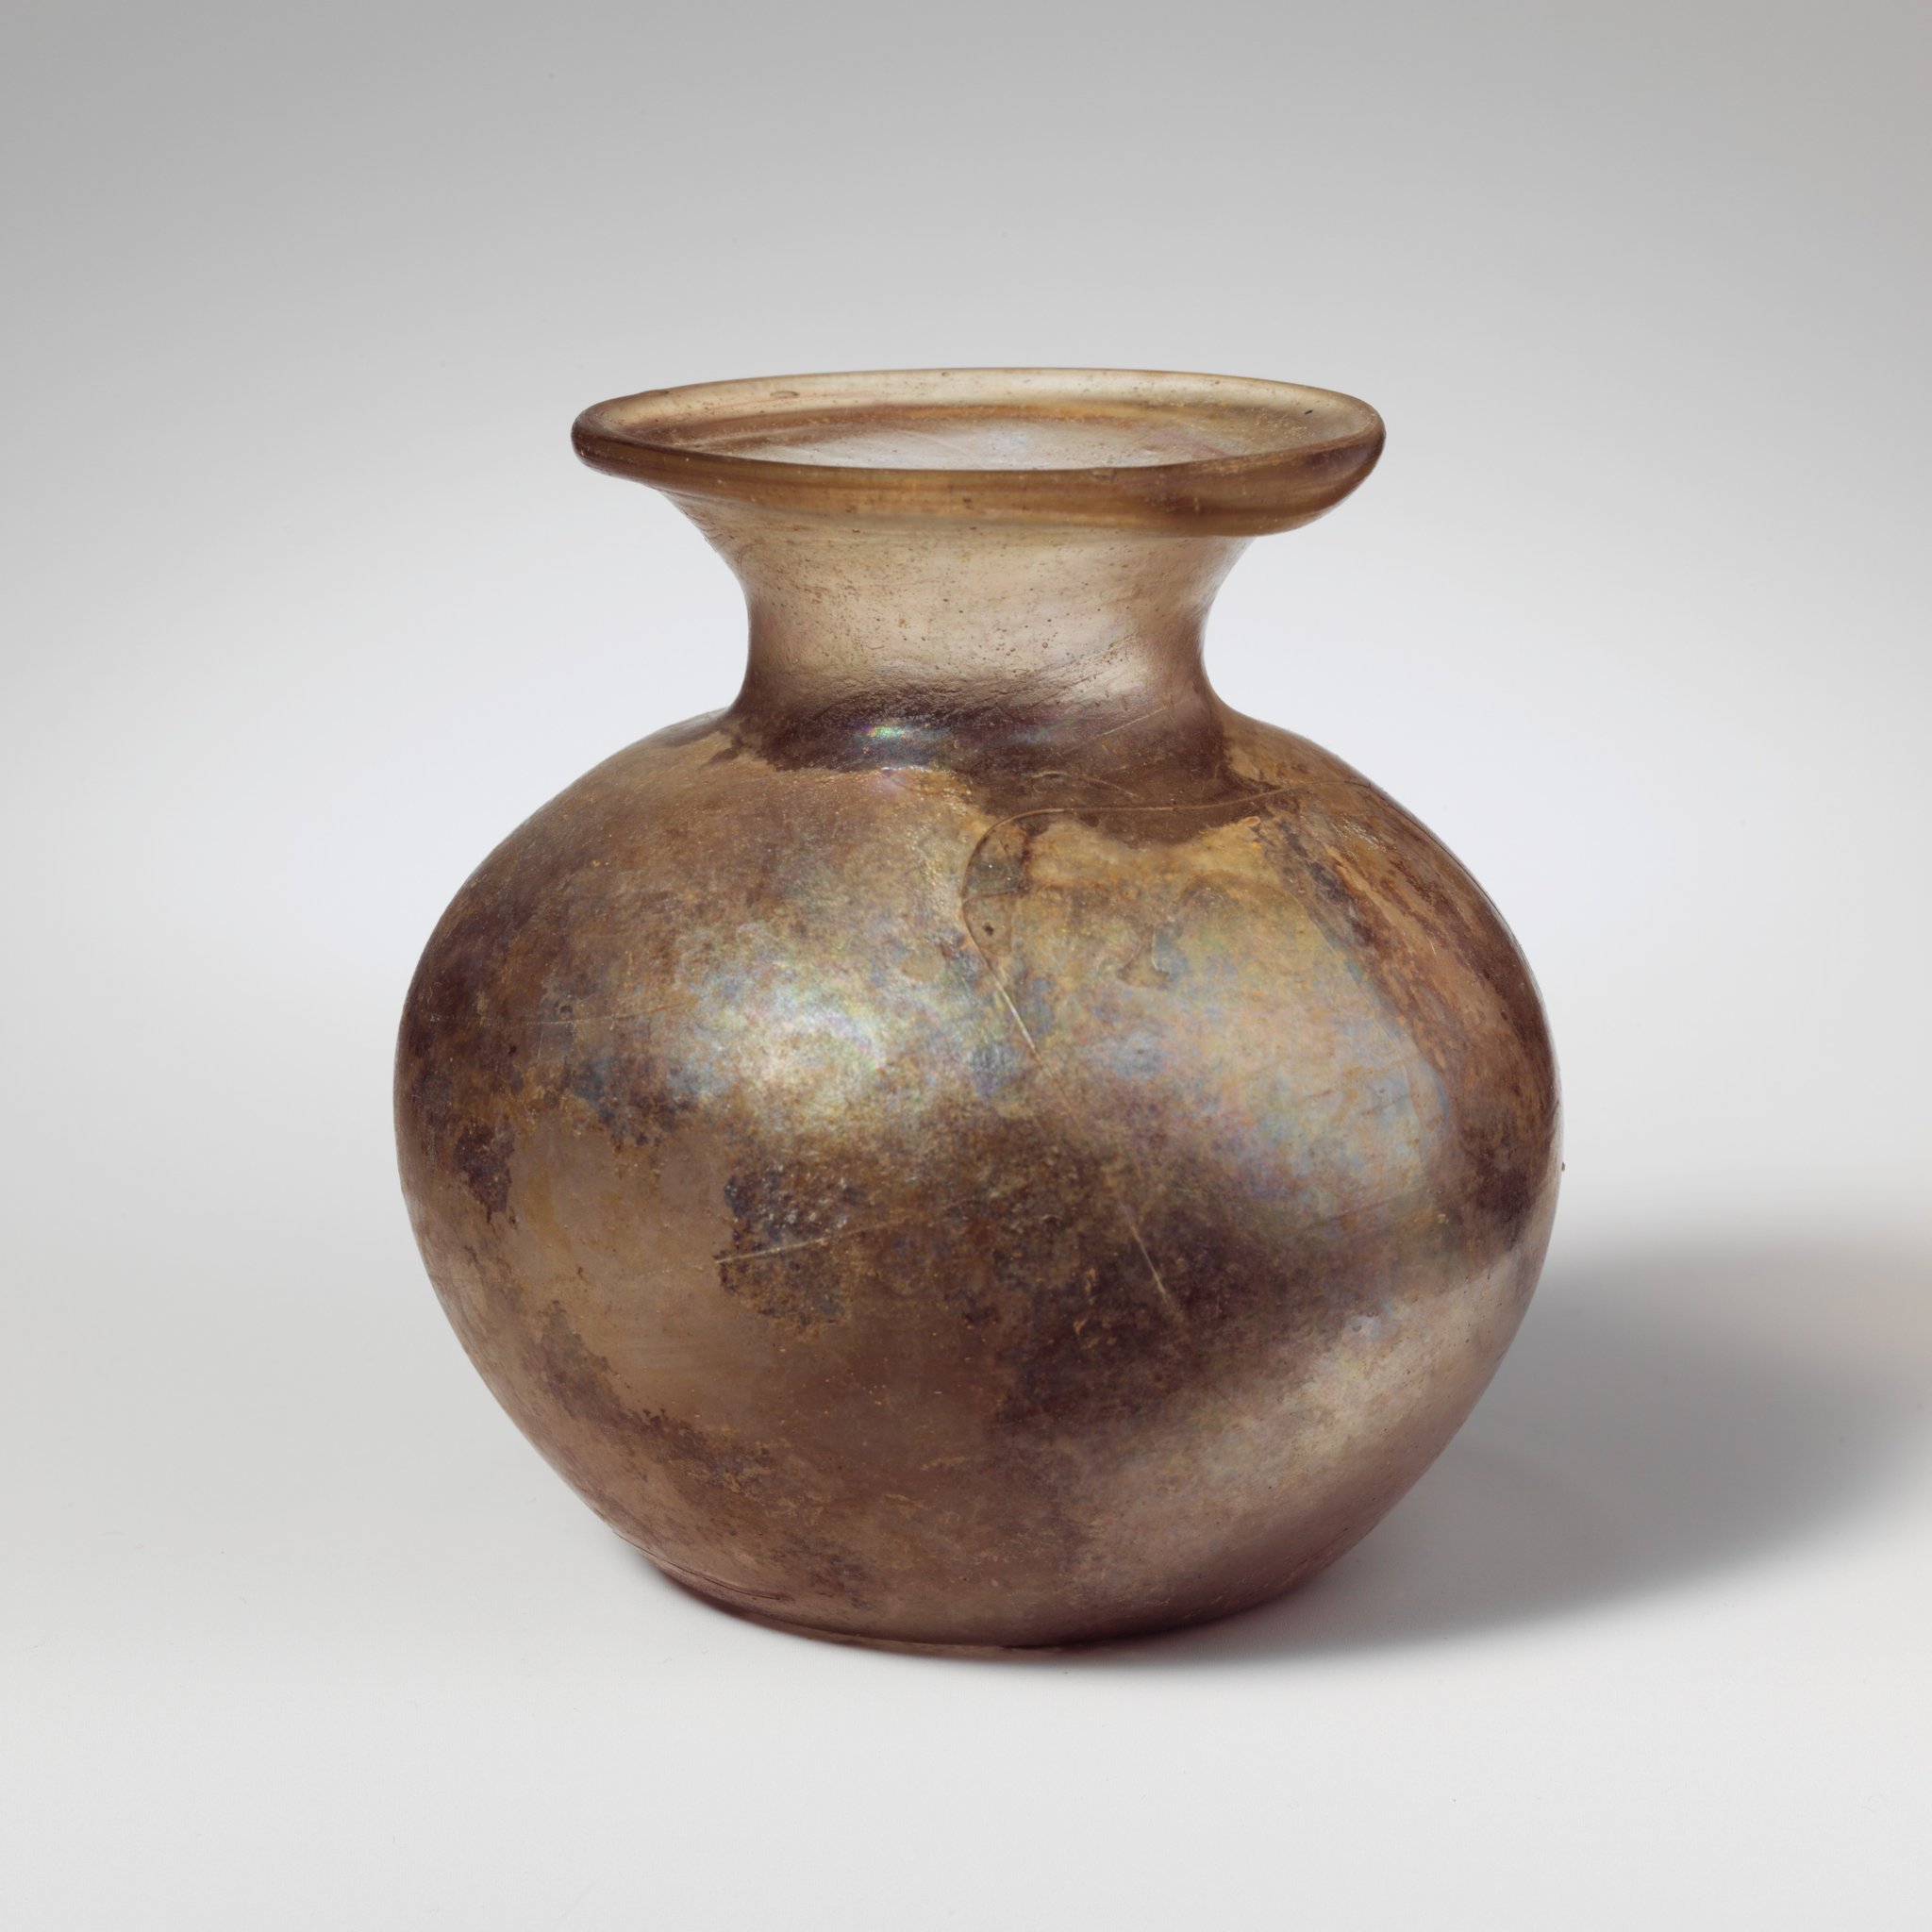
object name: jar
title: Glass jar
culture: roman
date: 101-300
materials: glass